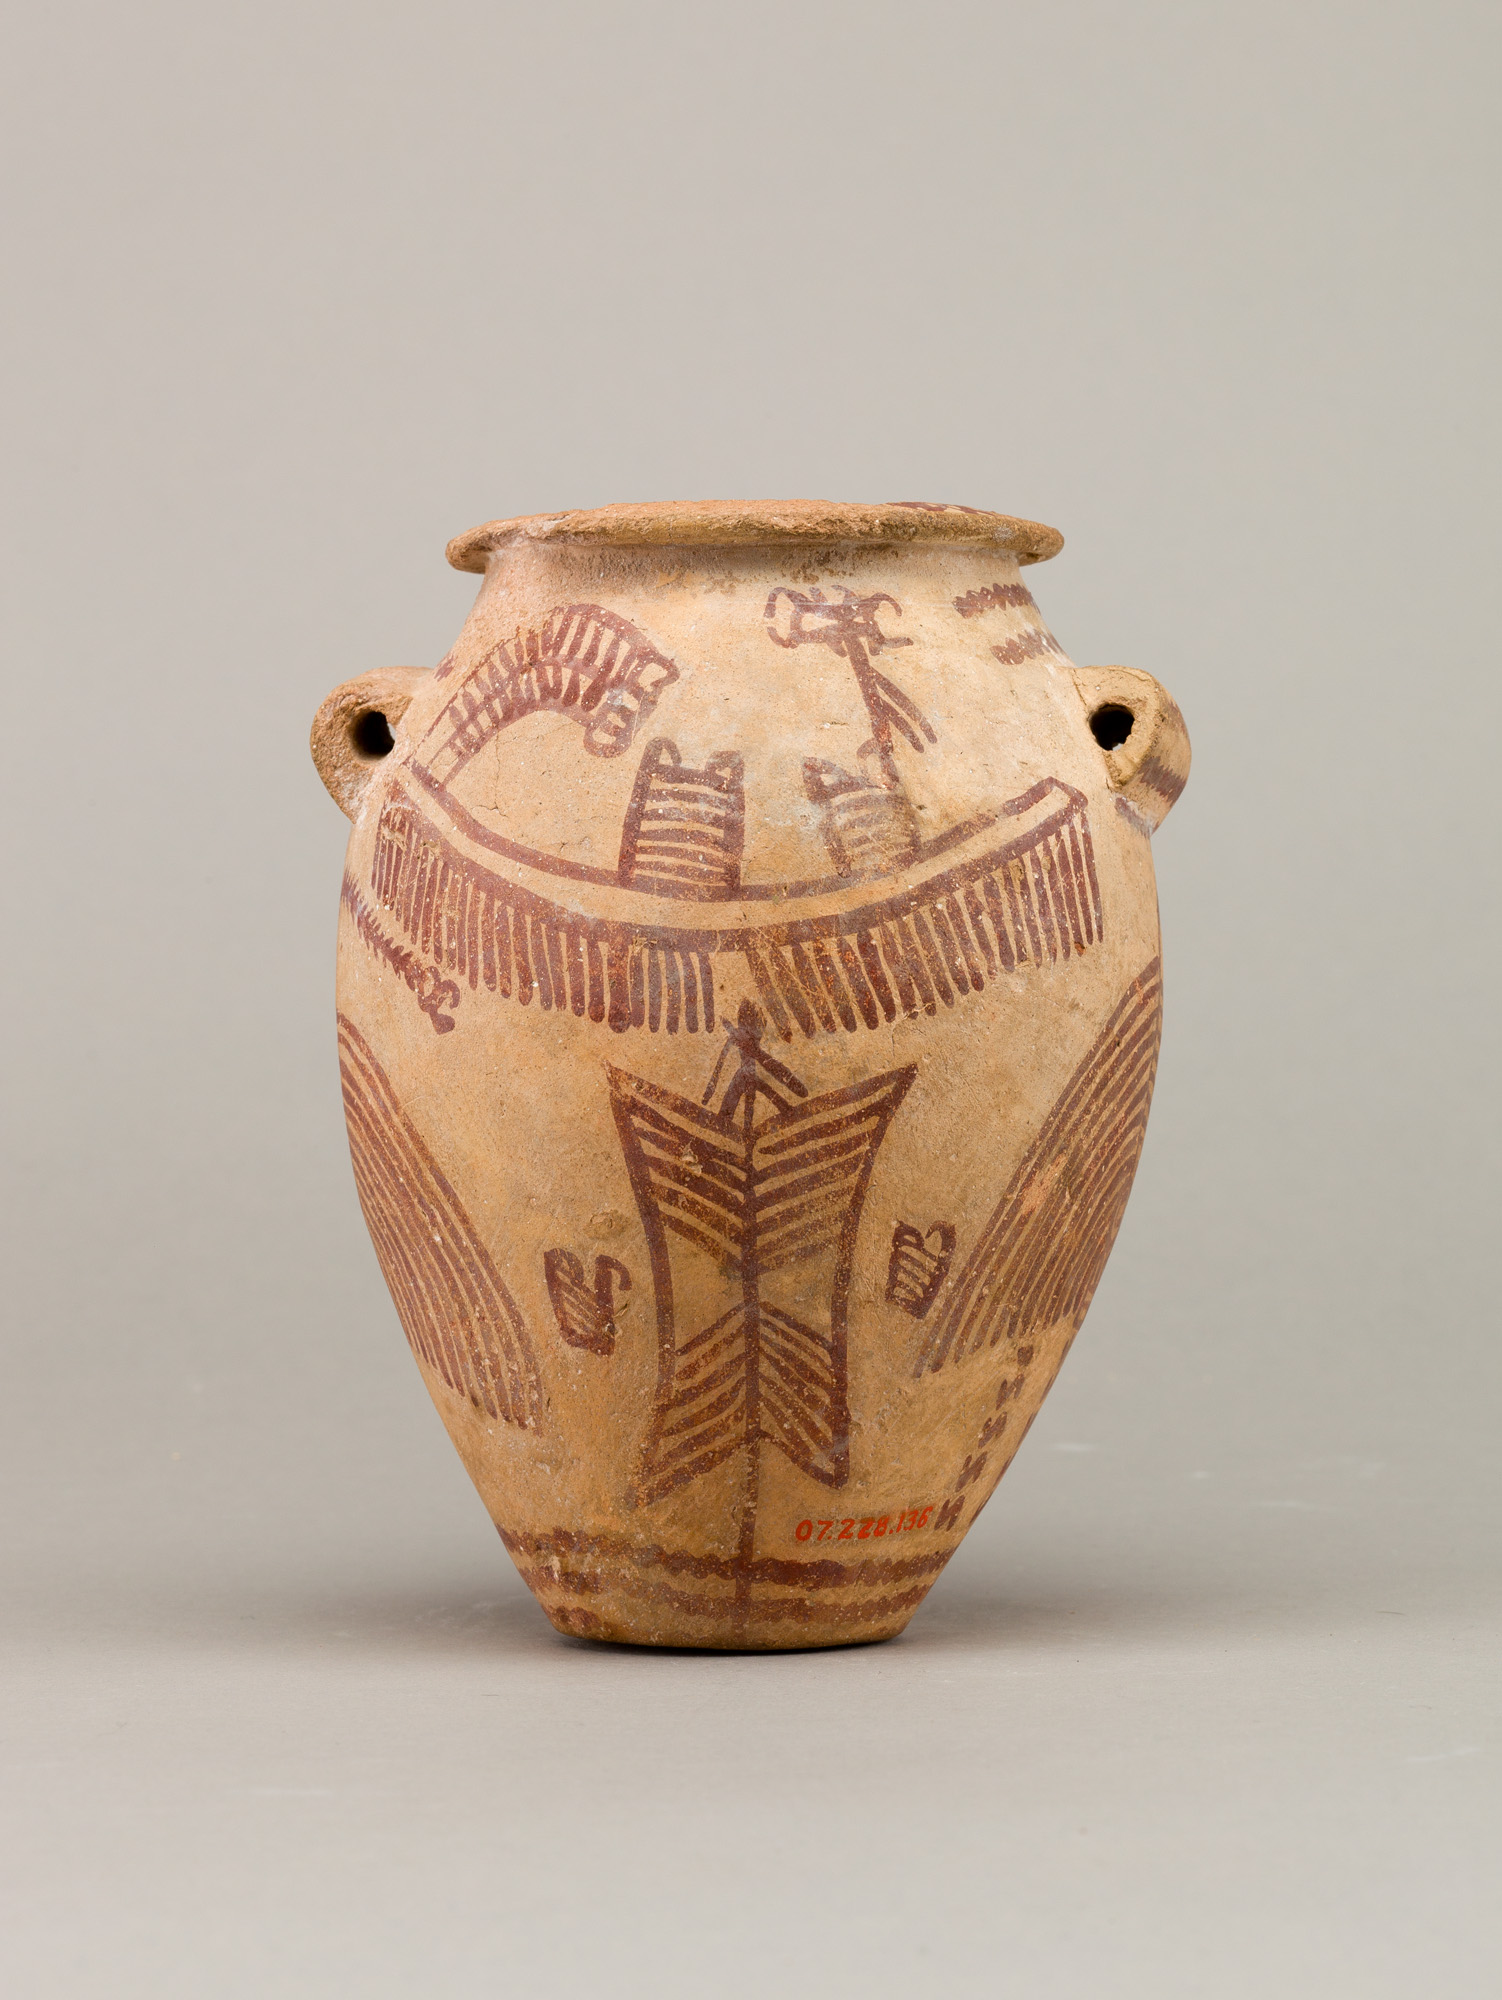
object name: jar, decorated ware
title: Decorated ware jar depicting boats and plants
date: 3850-2960 BCE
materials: paint, pottery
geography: egypt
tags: boats